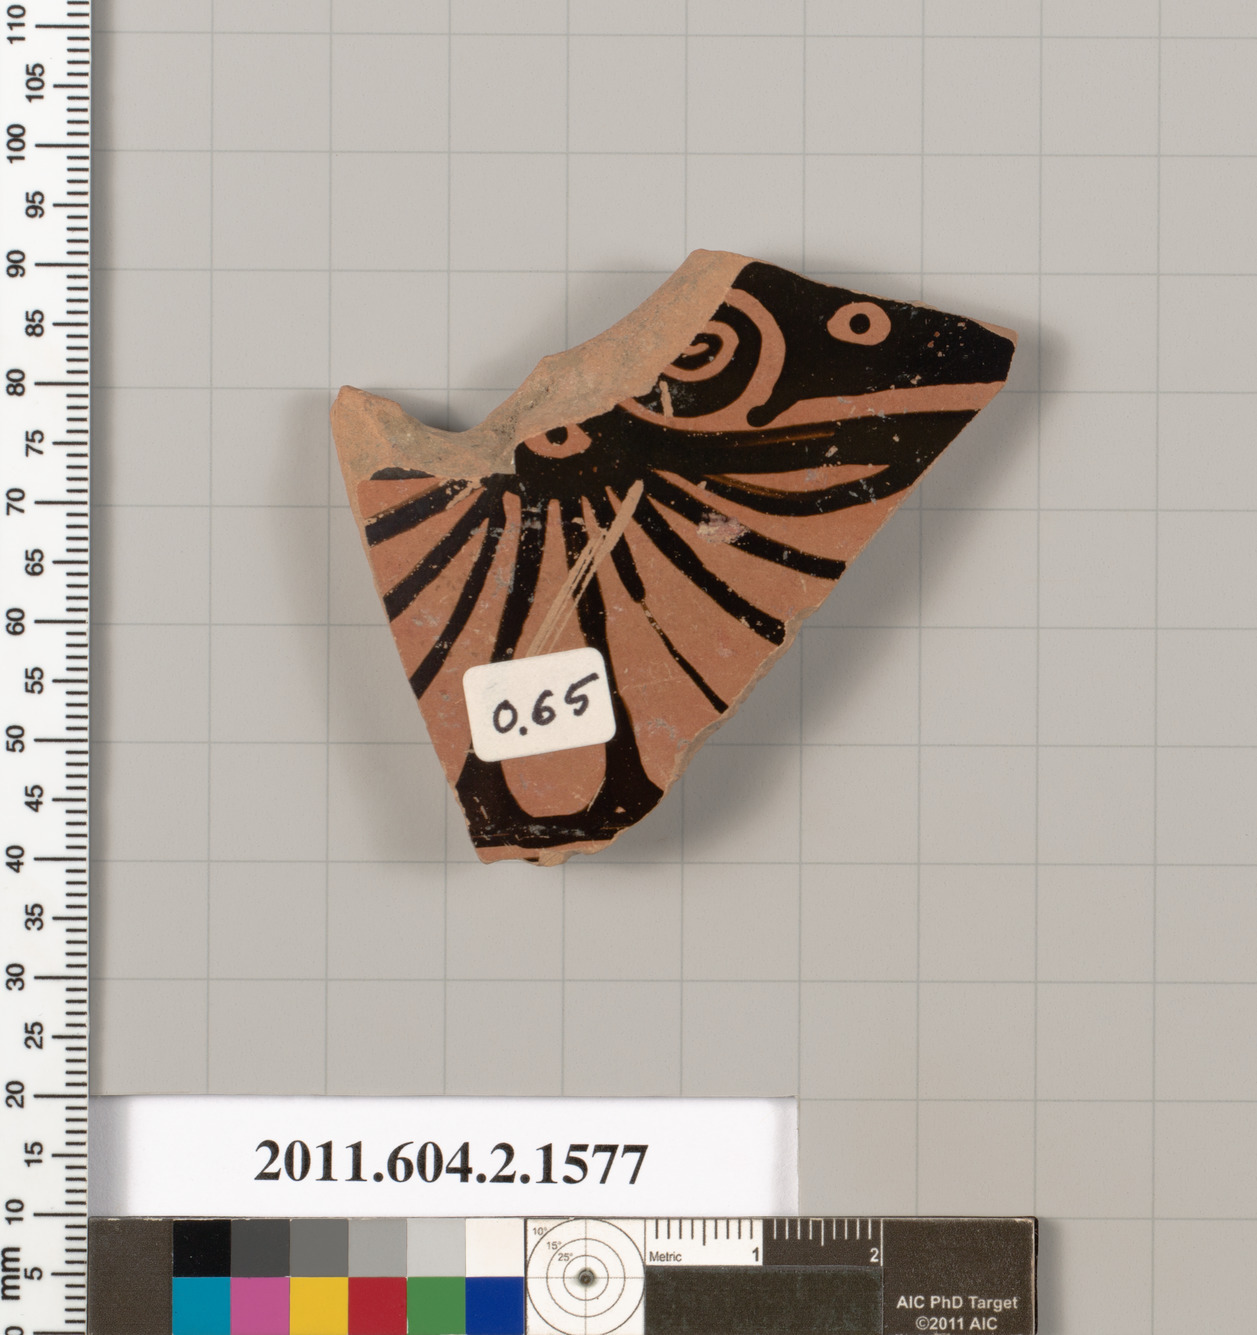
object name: skyphos fragment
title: Terracotta fragment of a skyphos (deep drinking cup)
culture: greek, attic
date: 450-426 BCE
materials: terracotta